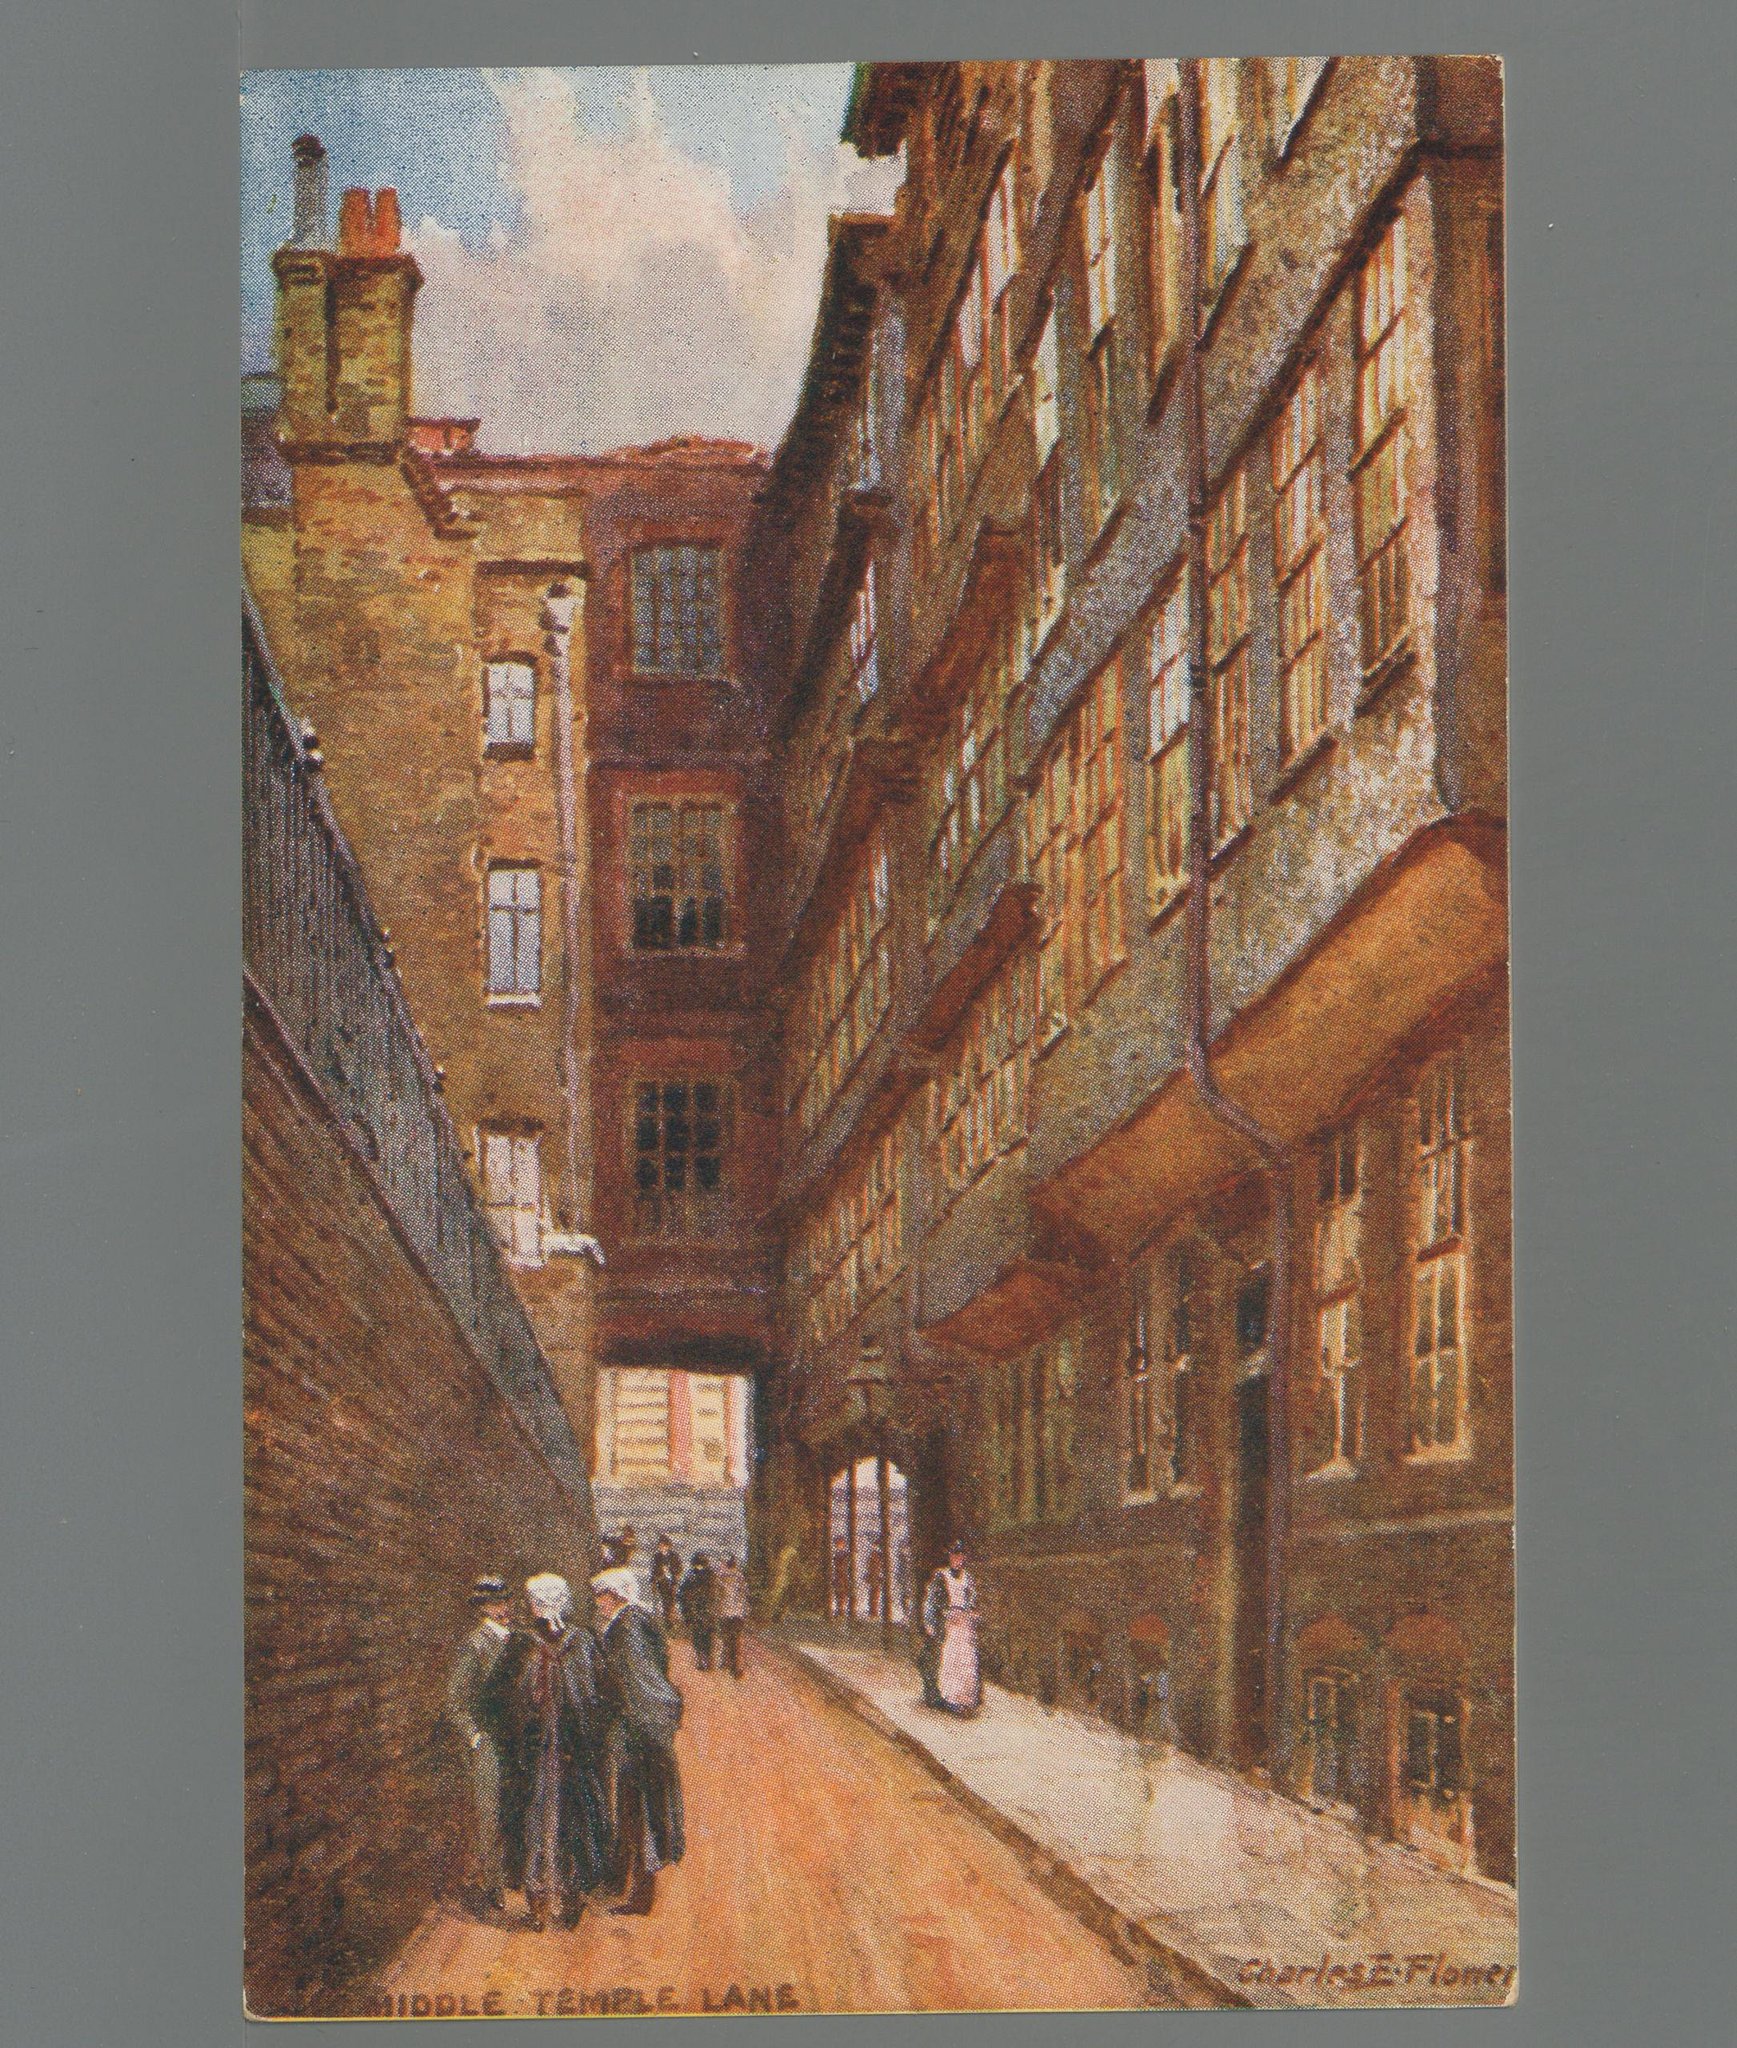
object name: ansichtkaart, prentbriefkaart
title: Oilette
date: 1904-1912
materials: cardboard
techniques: color autotype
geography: london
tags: court building, street, hotel, hostelry, inn, london